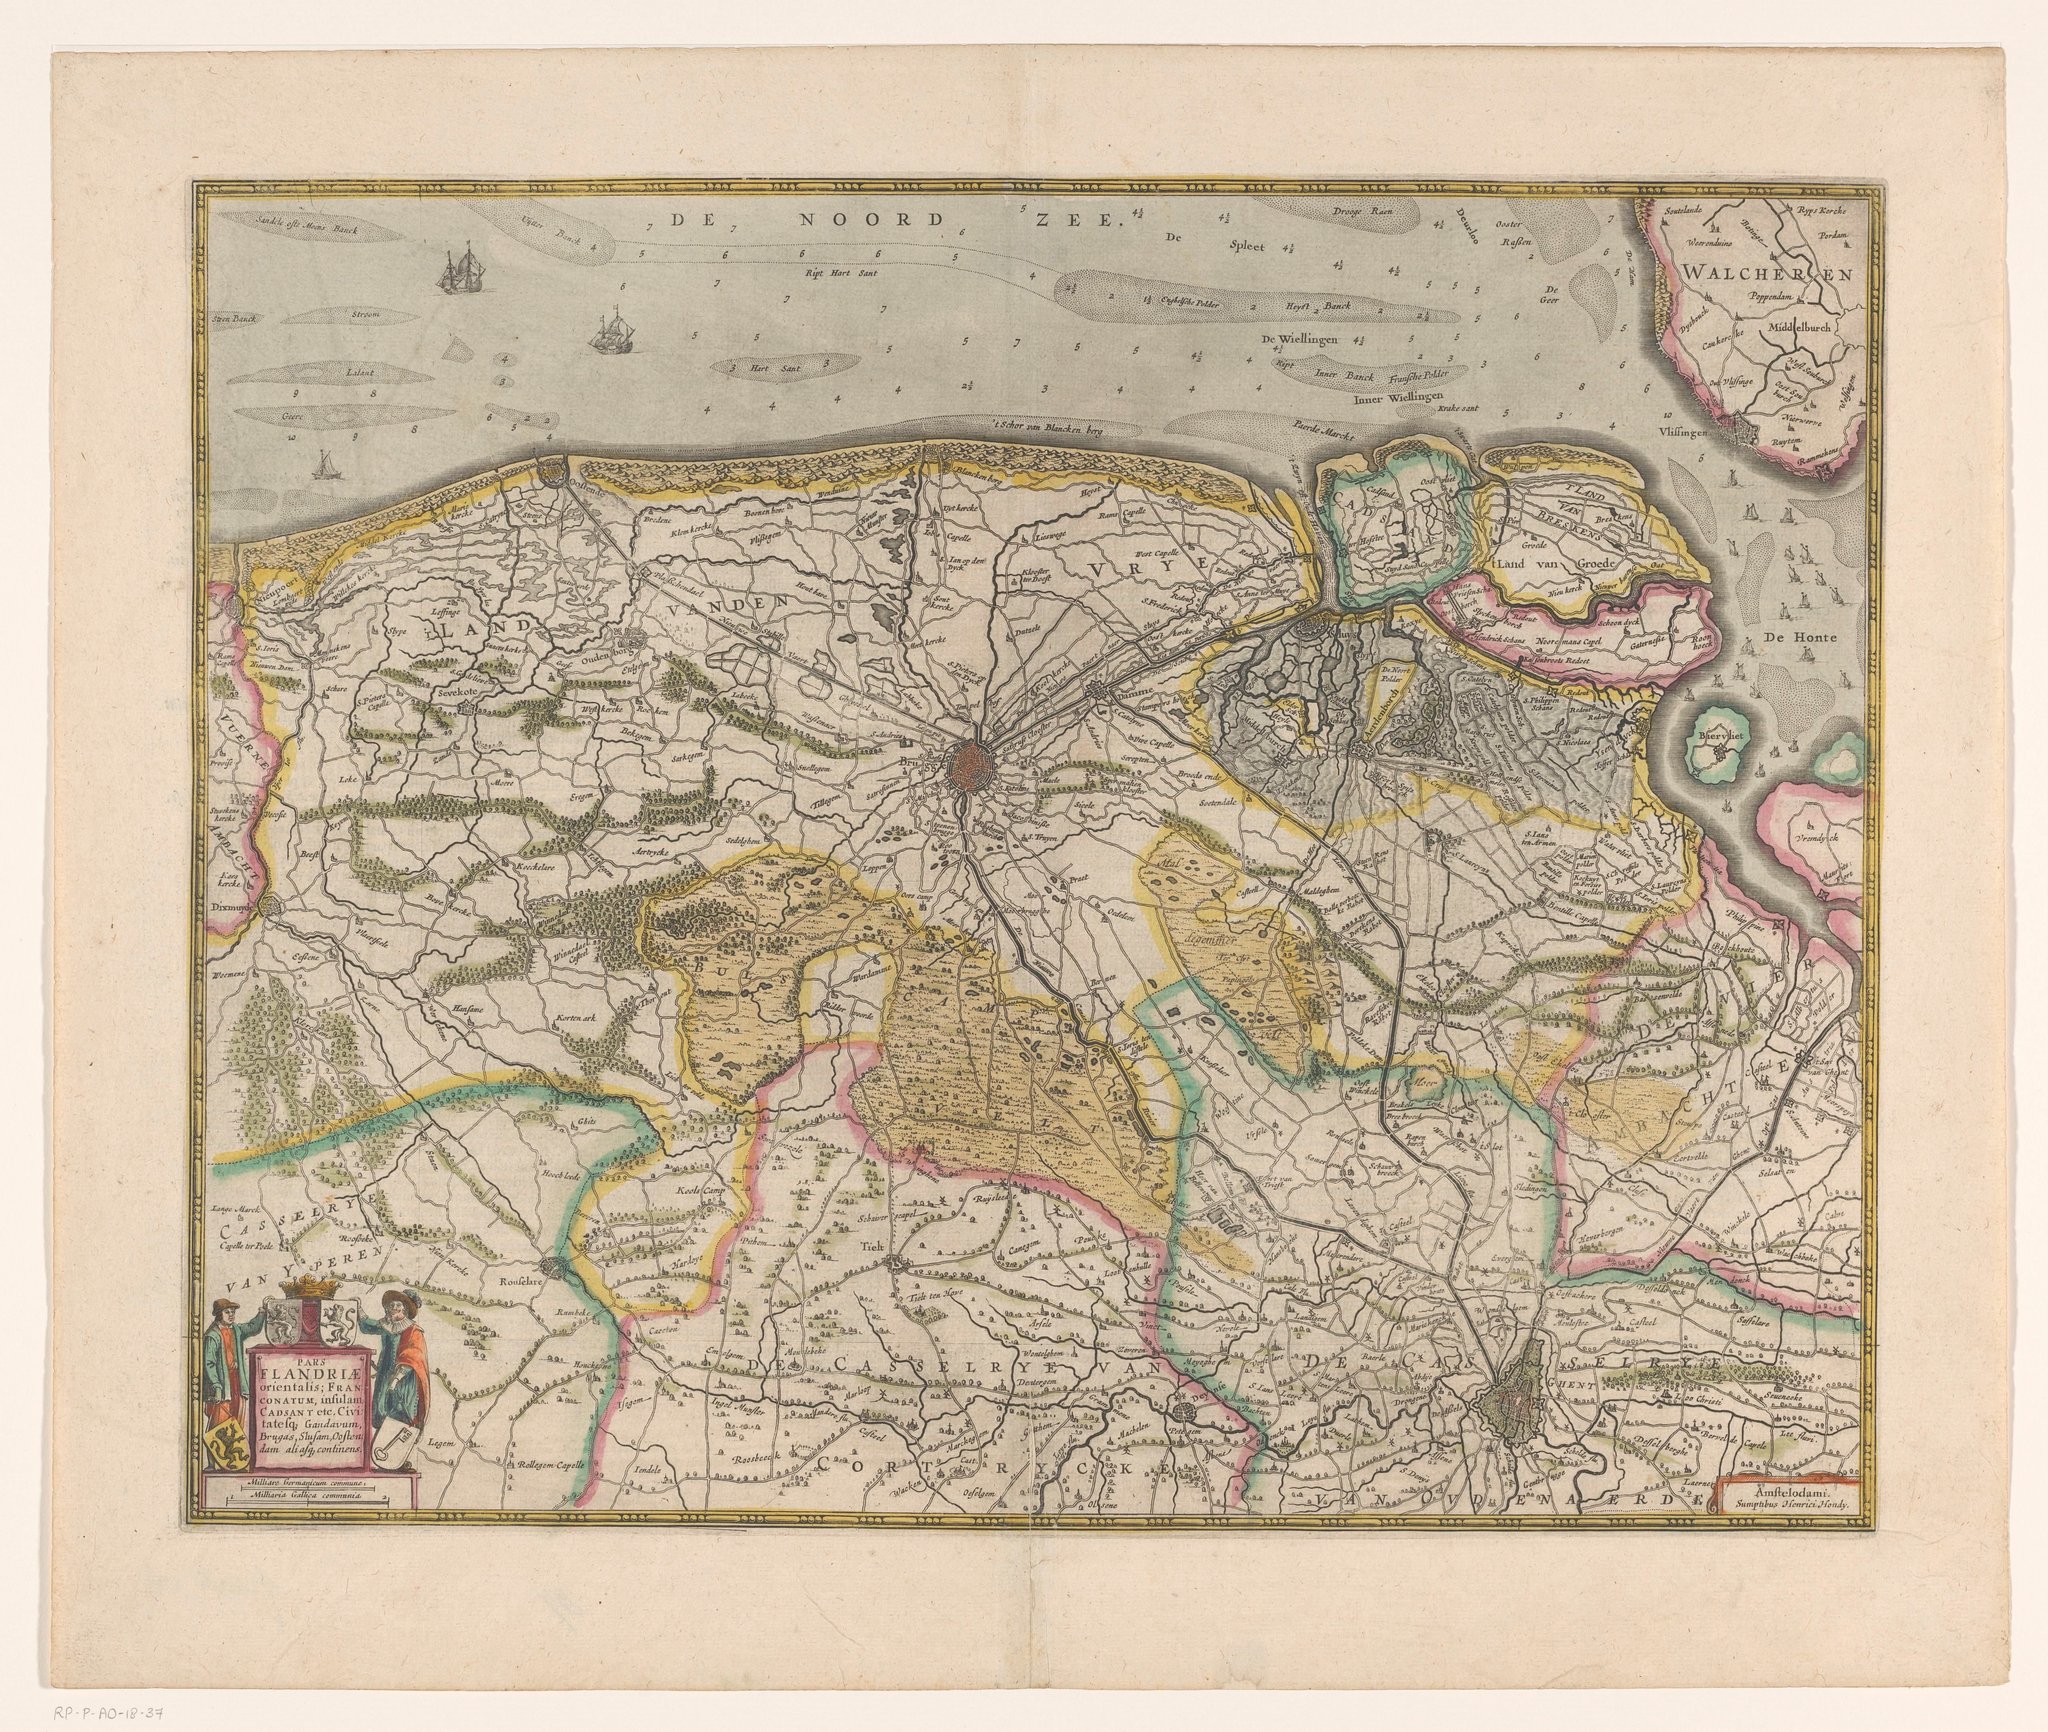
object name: print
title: Pars Flandriae orentalis; Franconatum, insulam Cadsant etc. (...)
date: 1633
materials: paper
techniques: engraving, etching, hand coloring, letterpress printing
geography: amsterdam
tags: coat of arms (as symbol of the state, etc.) (+ city; municipal), maps of separate countries or regions, folk costume, regional costume, coat of arms (as symbol of the state, etc.) (+ province; provincial)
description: Kaart van het Brugse Vrije, het grootste burggraafschap van het graafschap Vlaanderen. Linksonder de titelcartouche met onderin twee schaalstokken: Milliare Germanicum commune / 2 Milliaria Gallica communia. Aan de linkerzijde van de cartouche een kostuumfiguur met het wapen van het graafschap Vlaanderen, in spiegelbeeld, en aan de rechterzijde een kostuumfiguur met waarschijnlijk het wapen van Oostende. Boven de cartouche twee wapenschilden met leeuw, mogelijk de wapenschilden van Brugge en, nogmaals, het graafschap Vlaanderen. Met Franse tekst op verso.